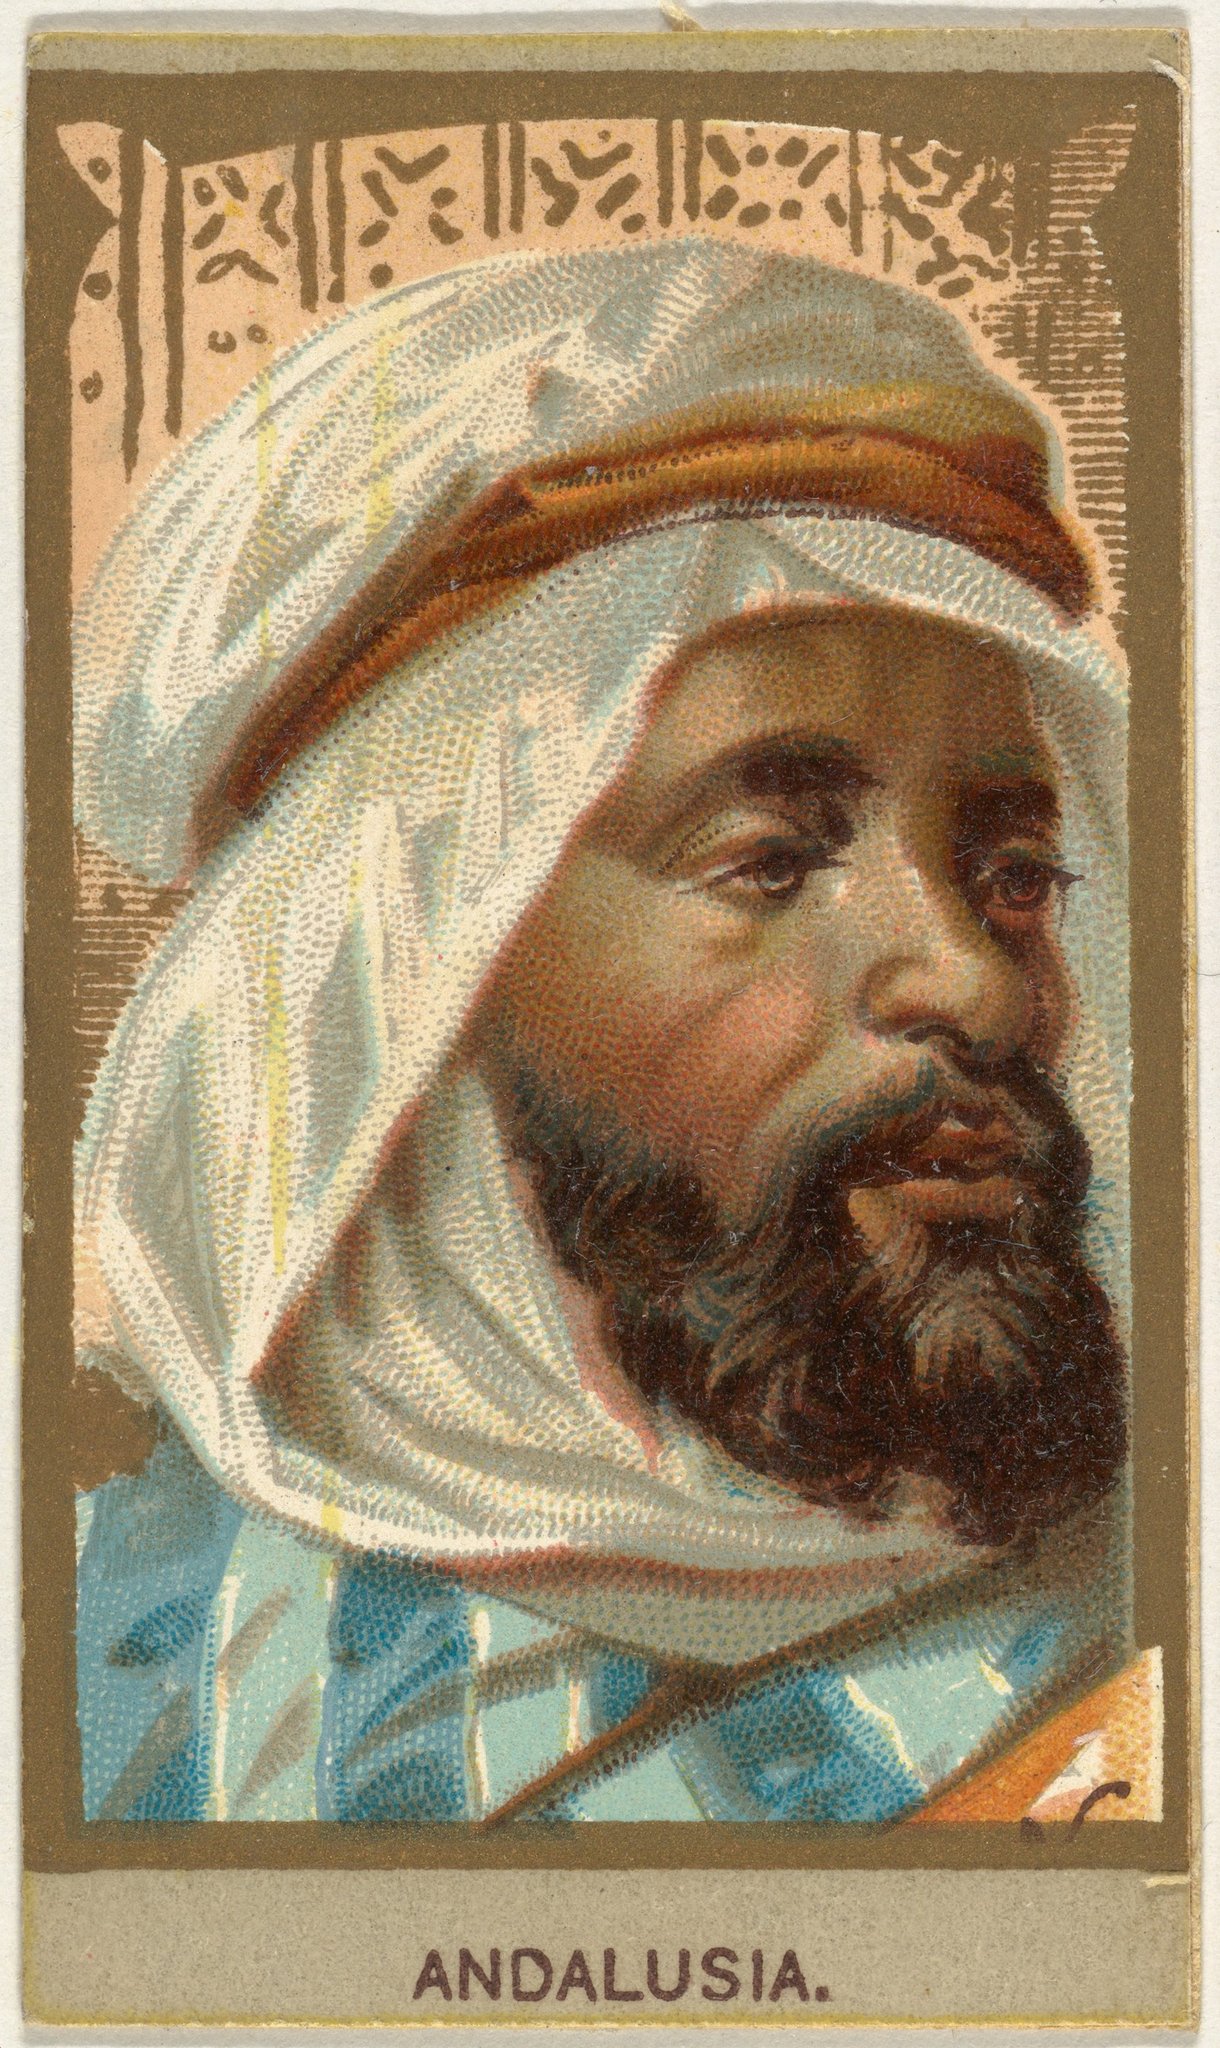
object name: print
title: Andalusia, from the Races of Mankind series (T181) issued by Abdul Cigarettes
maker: abdul cigarettes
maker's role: publisher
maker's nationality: american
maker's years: 1881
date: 1881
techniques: color lithograph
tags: men